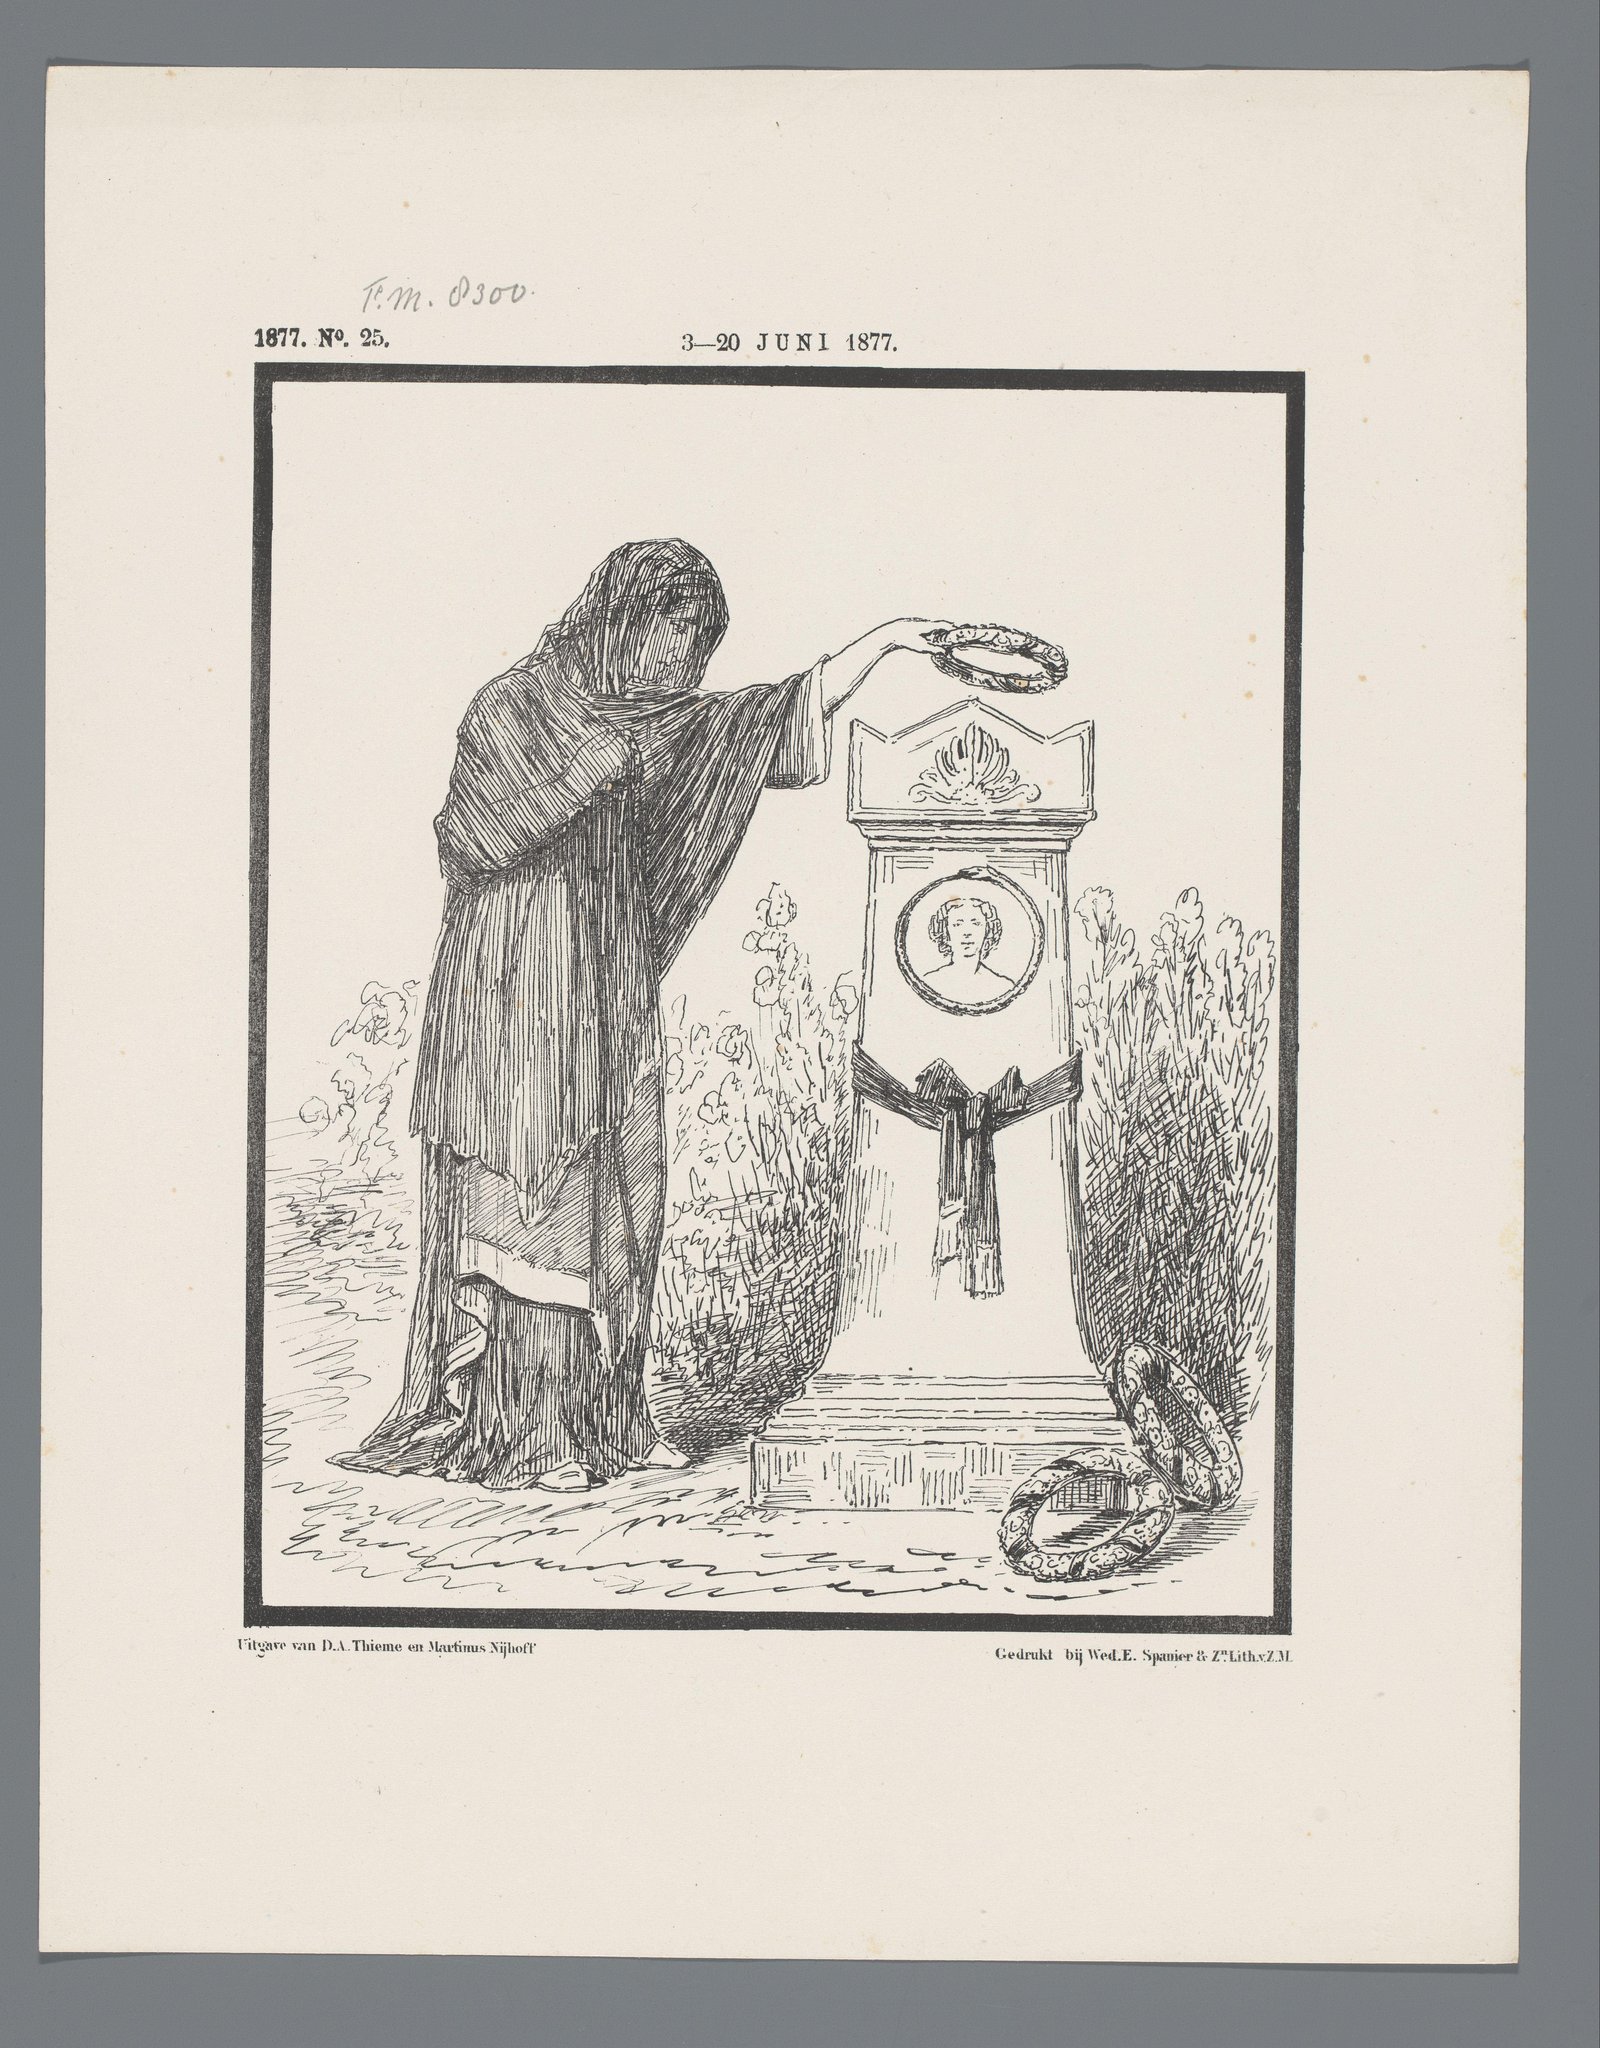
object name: print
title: Spotprent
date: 1877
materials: paper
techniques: lithograph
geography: netherlands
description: Spotprent . Plaat verschenen bij het weekblad De Nederlandsche Spectator, nr. 25, 1877.